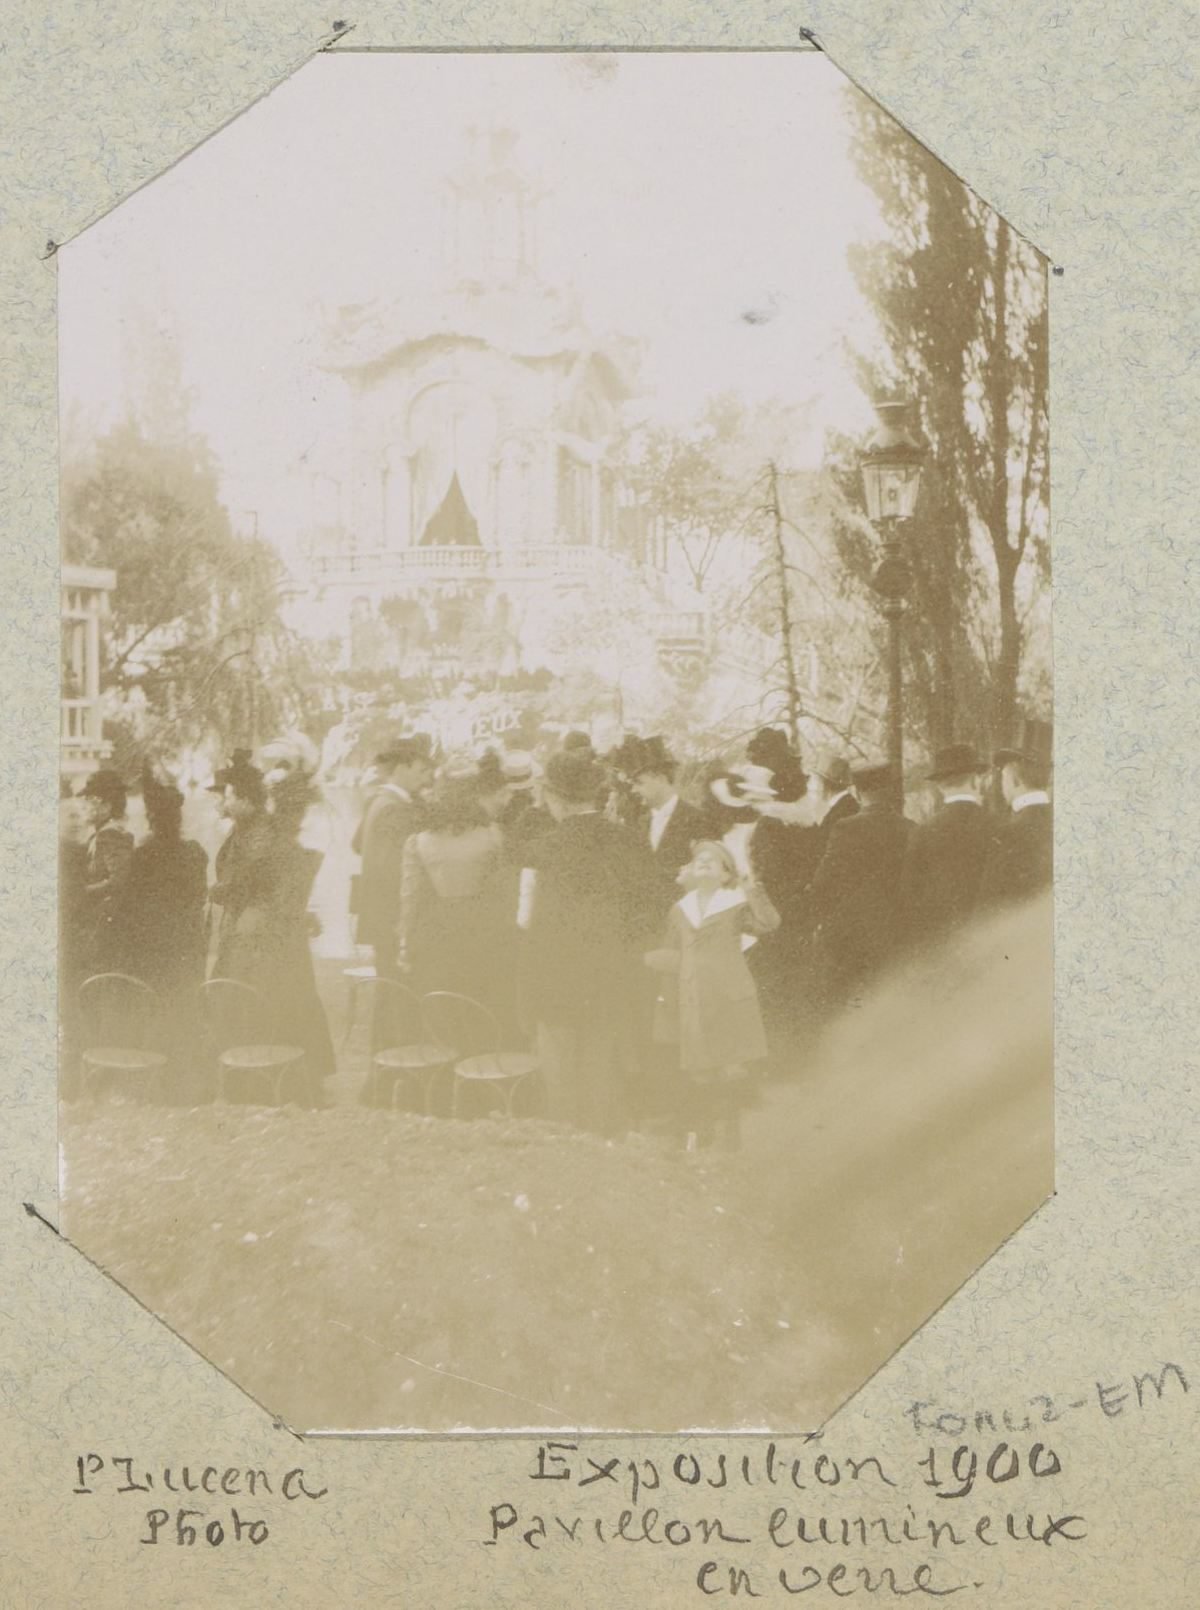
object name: photograph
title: Bezoekers van de Wereldtentoonstelling van 1900 voor een verlicht glazen paviljoen in Parijs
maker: paul lucena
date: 1900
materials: paper, photographic support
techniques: daylight paper print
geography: paris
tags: world fair, world exhibition, palace, paris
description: Onderdeel van Album van een Franse amateur met foto's van Frankrijk, Algerije, Palmyra, de Wereldtentoonstelling van 1900 en van bekende Fransen.